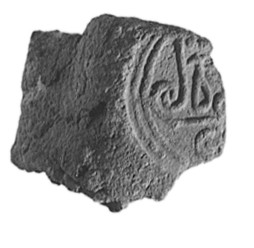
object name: sealing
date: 2030-1640 BCE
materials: clay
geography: egypt